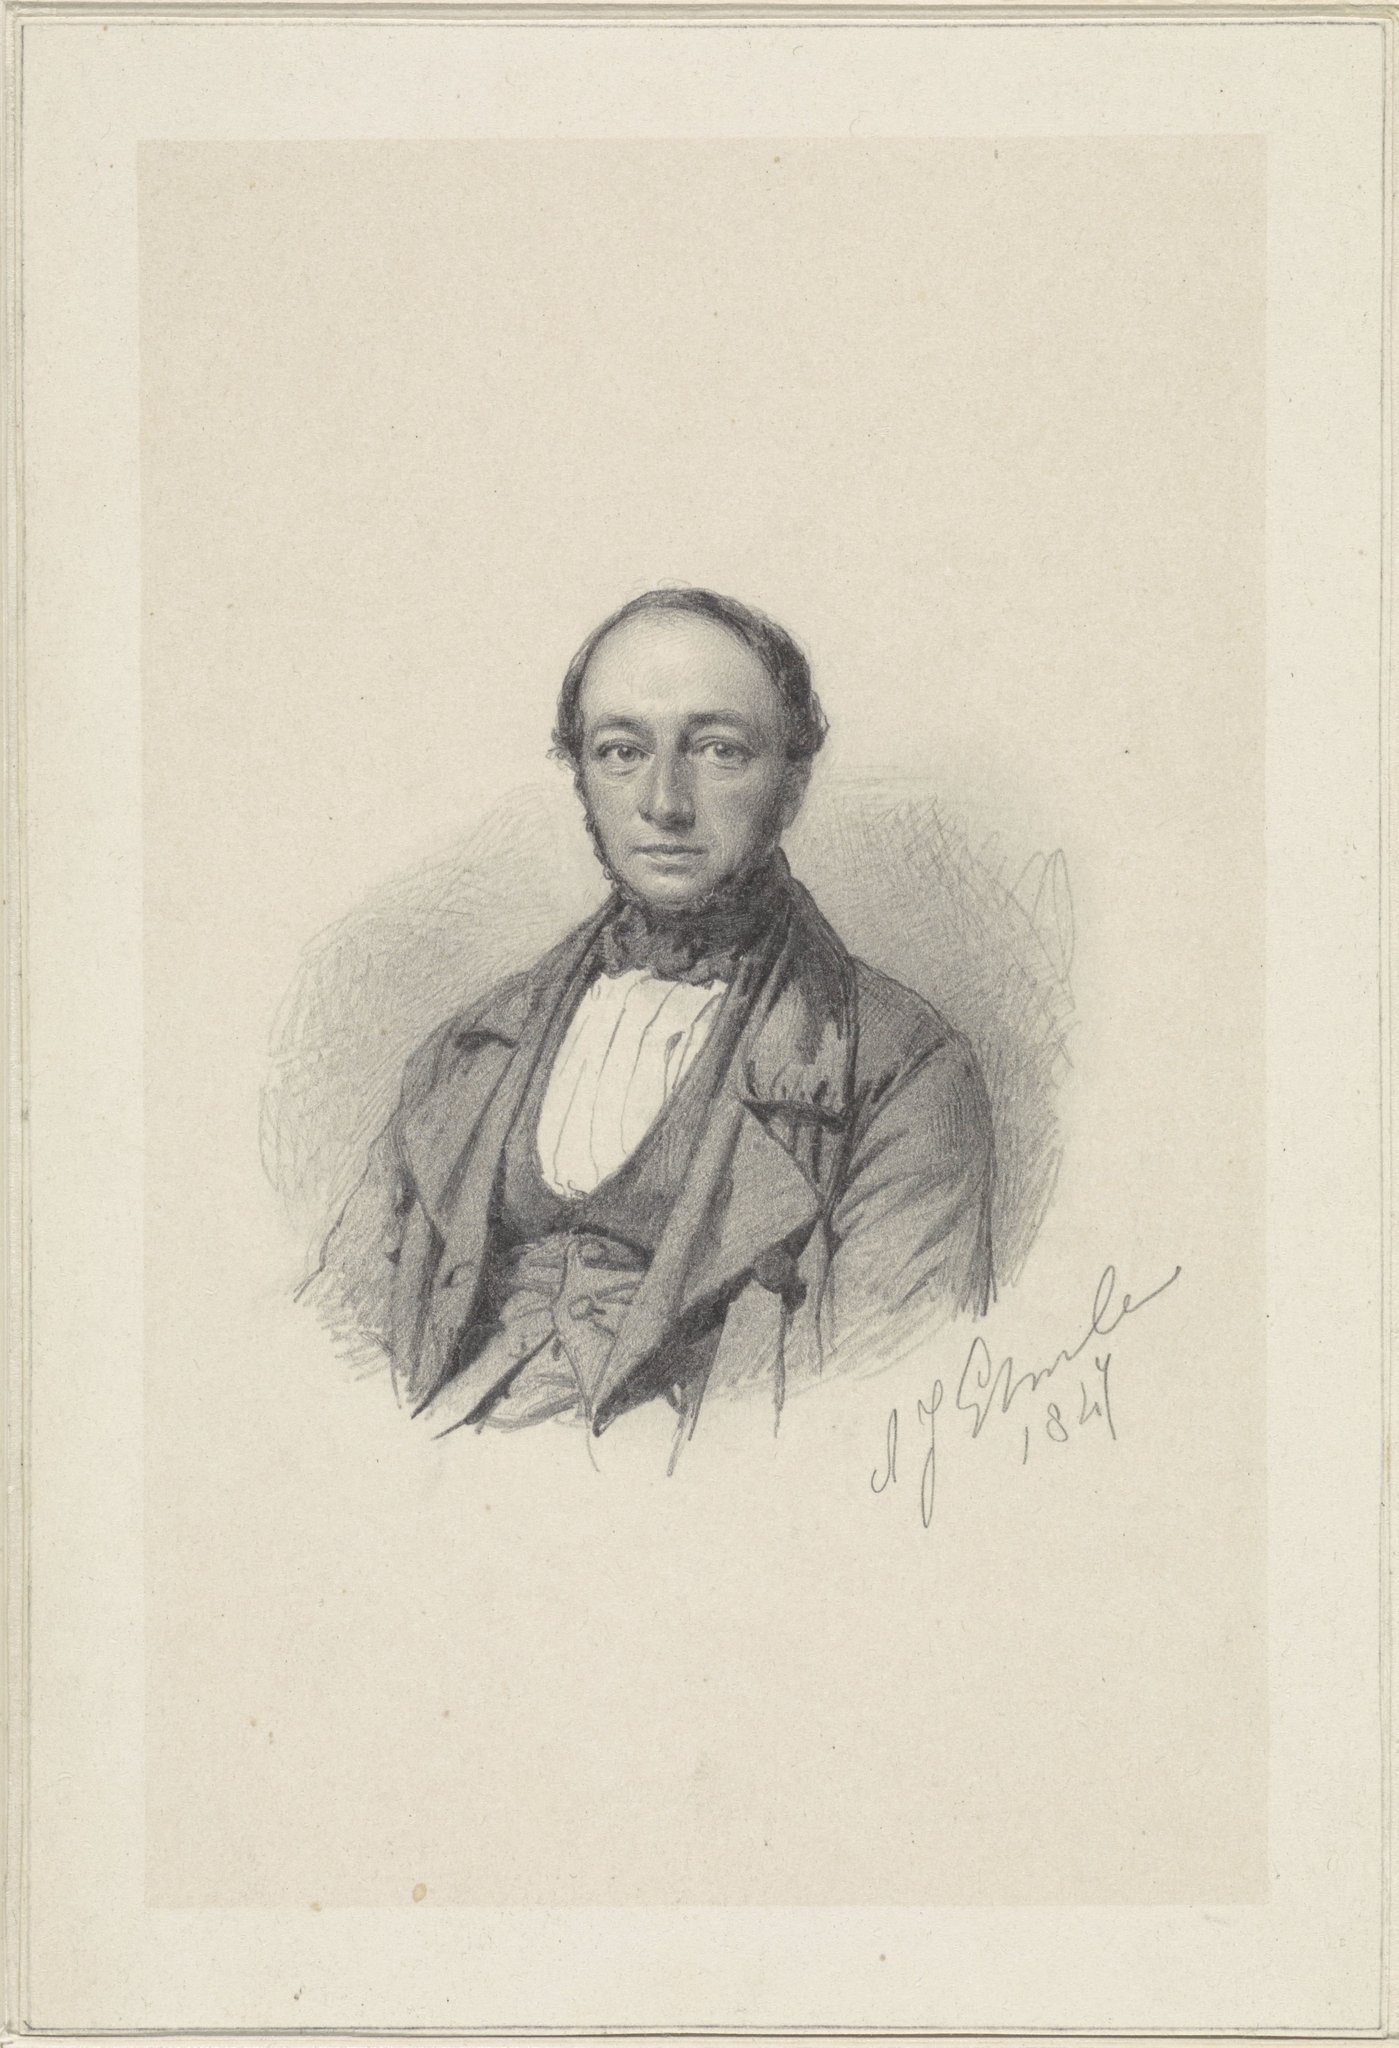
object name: drawing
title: Portret van Arnoldus Johannes Eymer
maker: adrianus johannes ehnle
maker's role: draughtsman, print maker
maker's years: 1819-1863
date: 1847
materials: paper, pencil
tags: amsterdam, arnoldus johannes eymer, historical persons, portrait, self-portrait of painter, portrait, self-portrait of artist, portrait, self-portrait of draughtsman